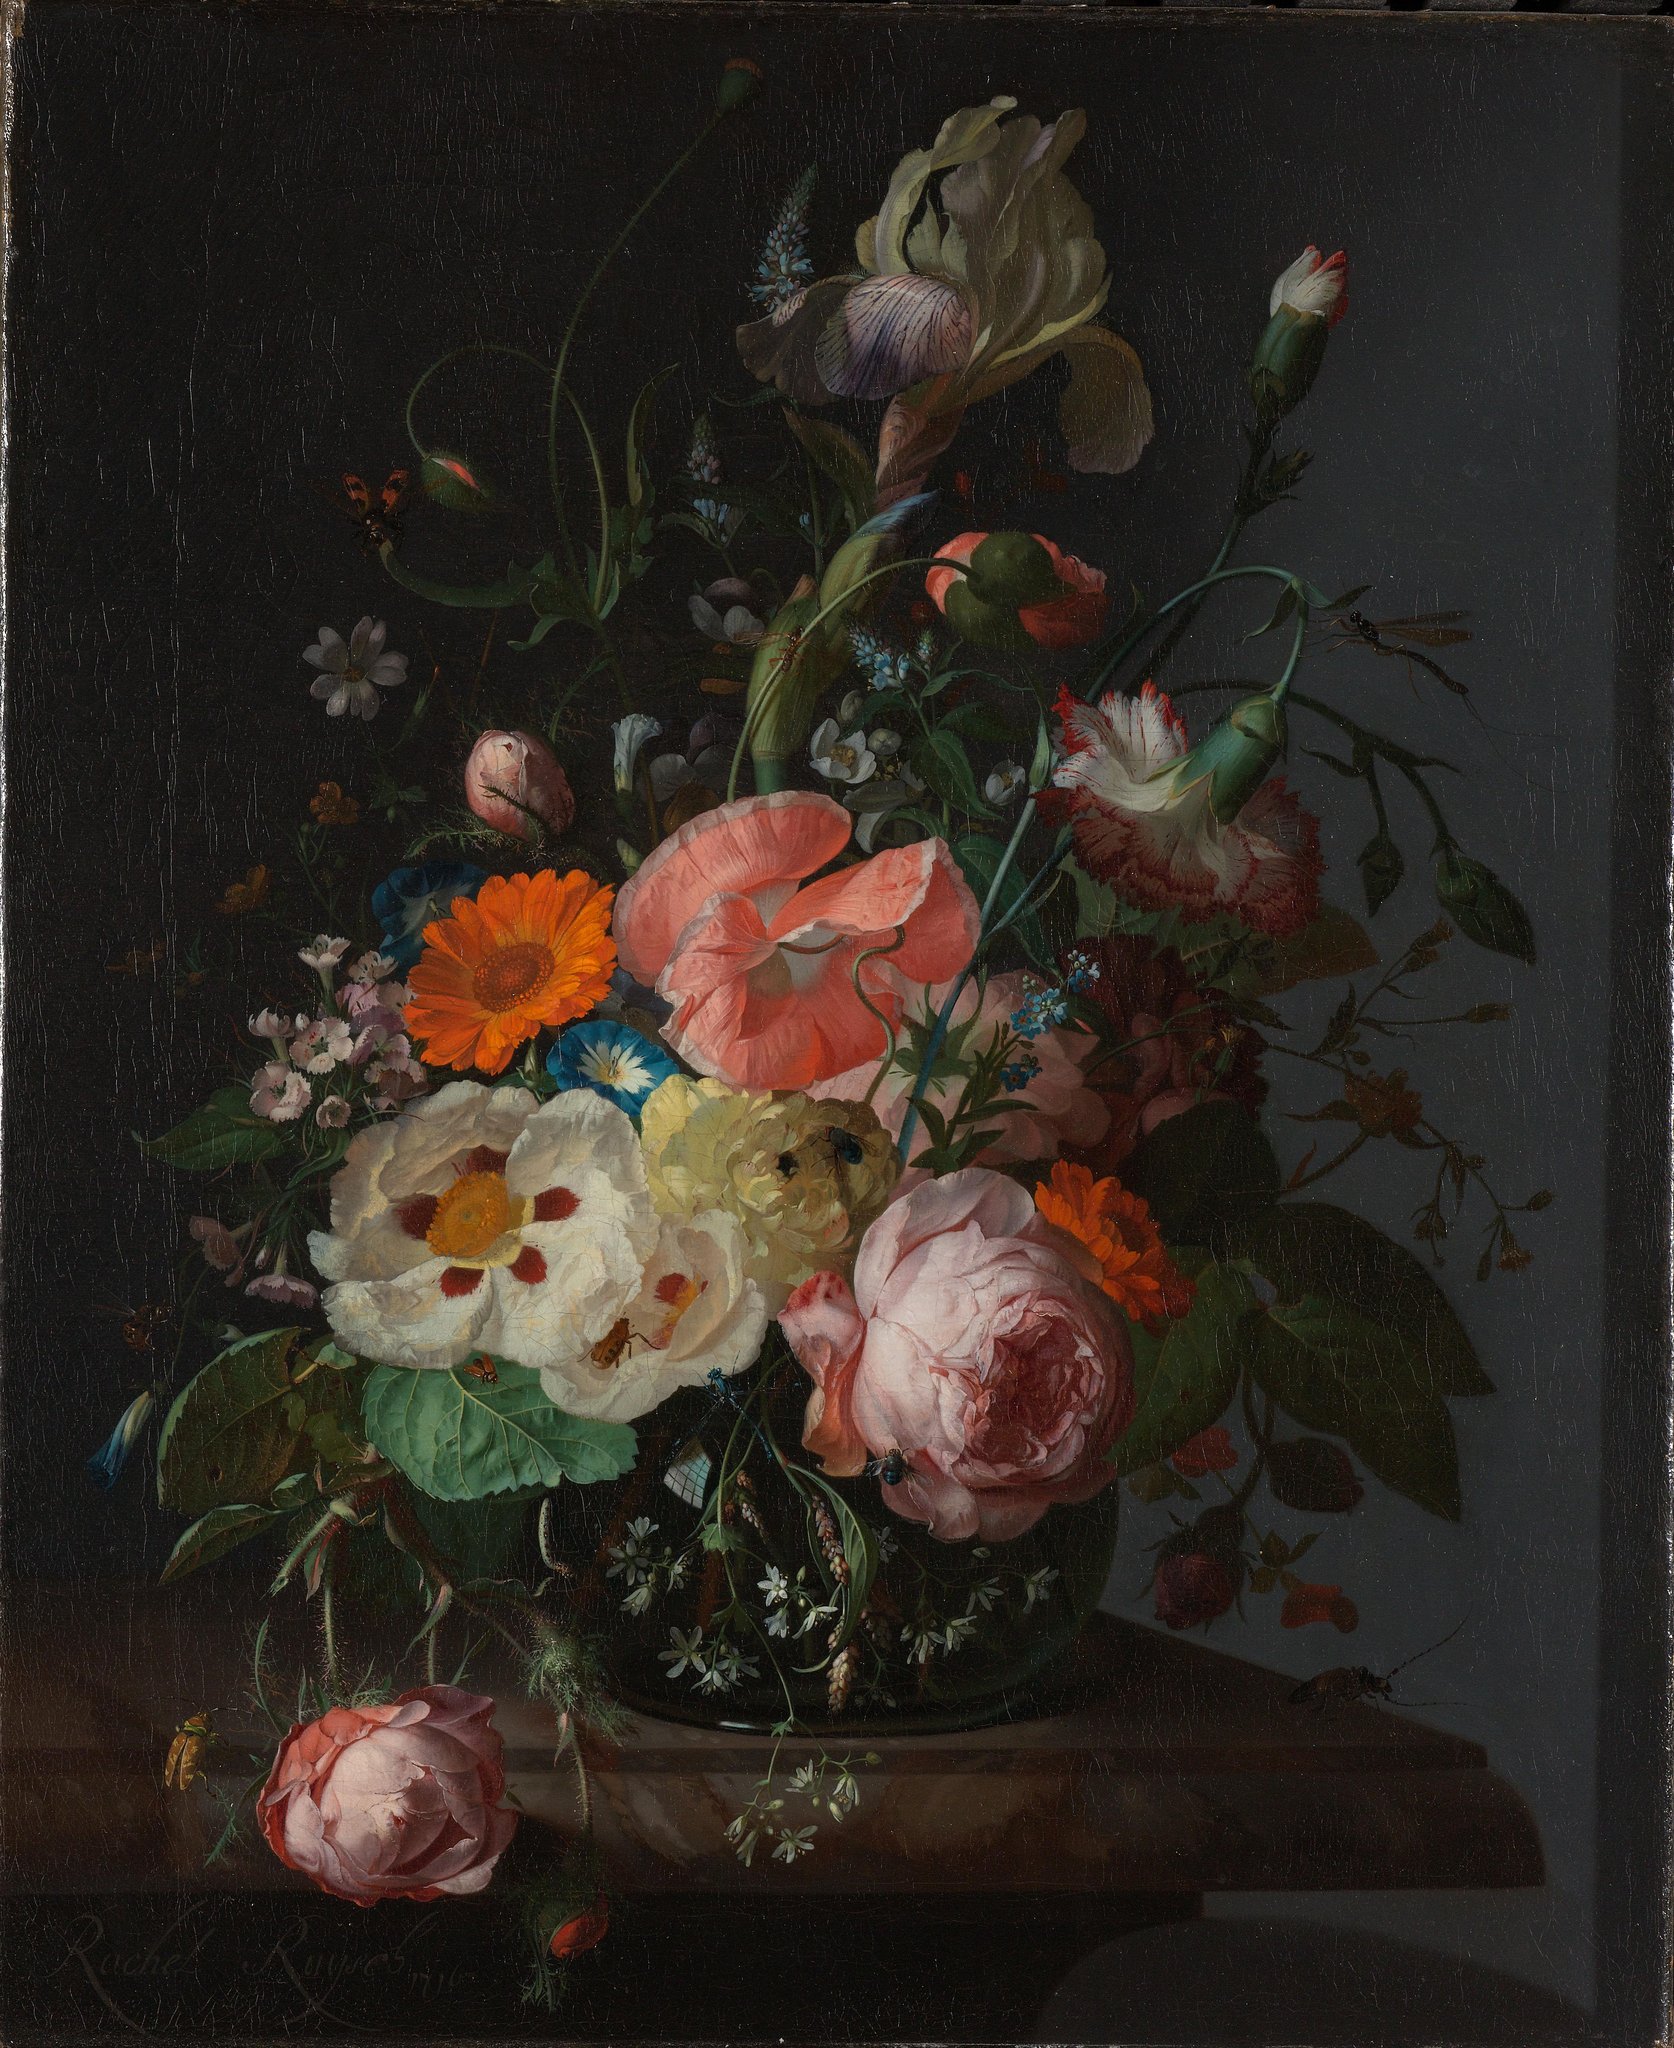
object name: painting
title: Still Life with Flowers on a Marble Tabletop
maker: rachel ruysch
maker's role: painter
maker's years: 1664-1750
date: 1716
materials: canvas, oil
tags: flowers in a vase, insects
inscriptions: signature and date: ‘Rachel Ruysch 1716’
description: This bouquet features more than ten species of flowers and teems with insects. As the blossoms flower at different times, it would be rather difficult to assemble such a bouquet in real life. Ruysch was well aware of this: her extensive study of live and prepared flowers allowed her to paint these vibrant bouquets with stunning precision. During her lifetime, she was one of the most celebrated painters of floral still lifes in Europe.